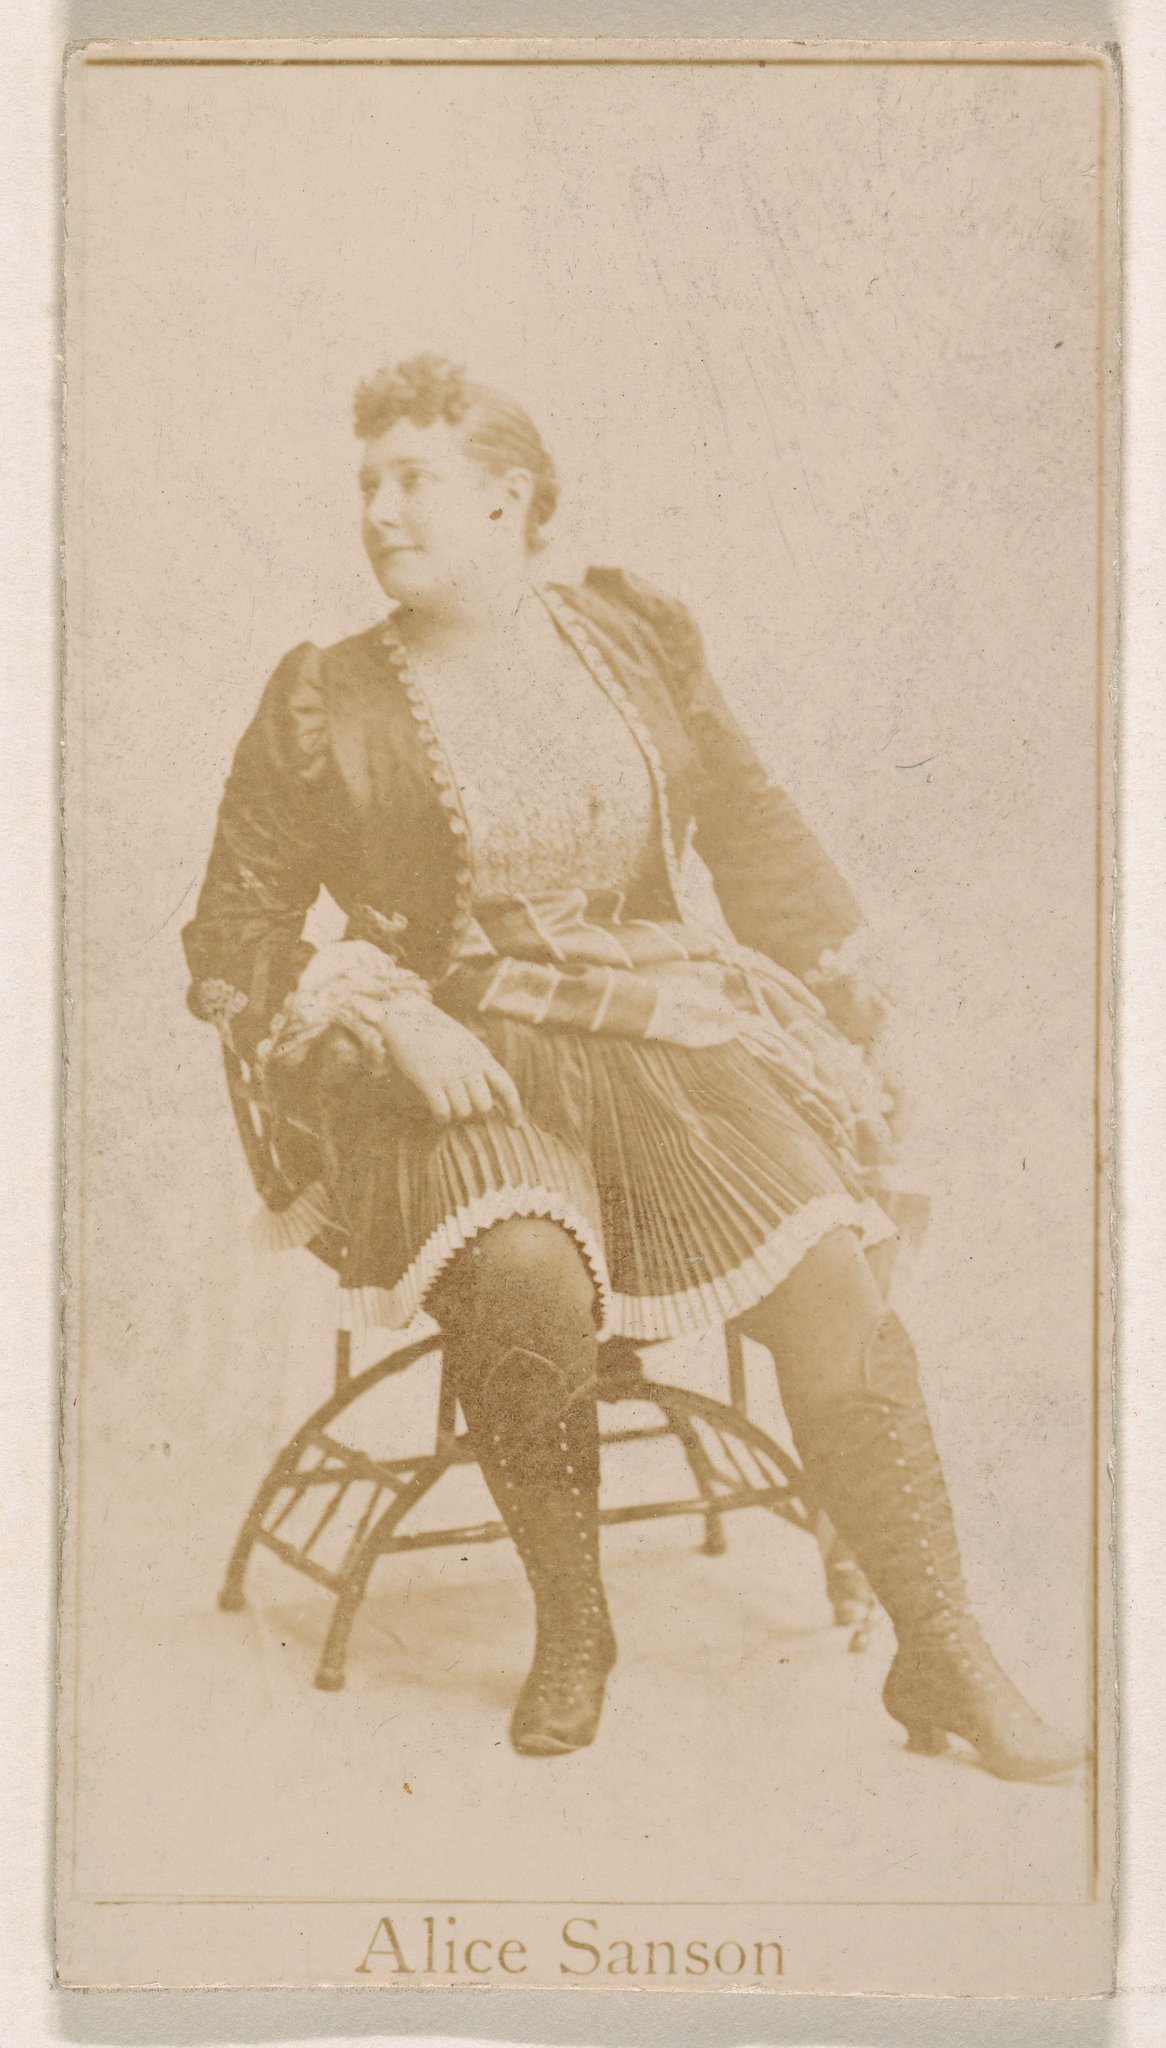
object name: photograph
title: Alice Sanson, from the Actresses series (N245) issued by Kinney Brothers to promote Sweet Caporal Cigarettes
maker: kinney brothers tobacco company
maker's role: publisher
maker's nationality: american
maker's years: 1869-2011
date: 1890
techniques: albumen silver print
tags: portraits,women,actresses